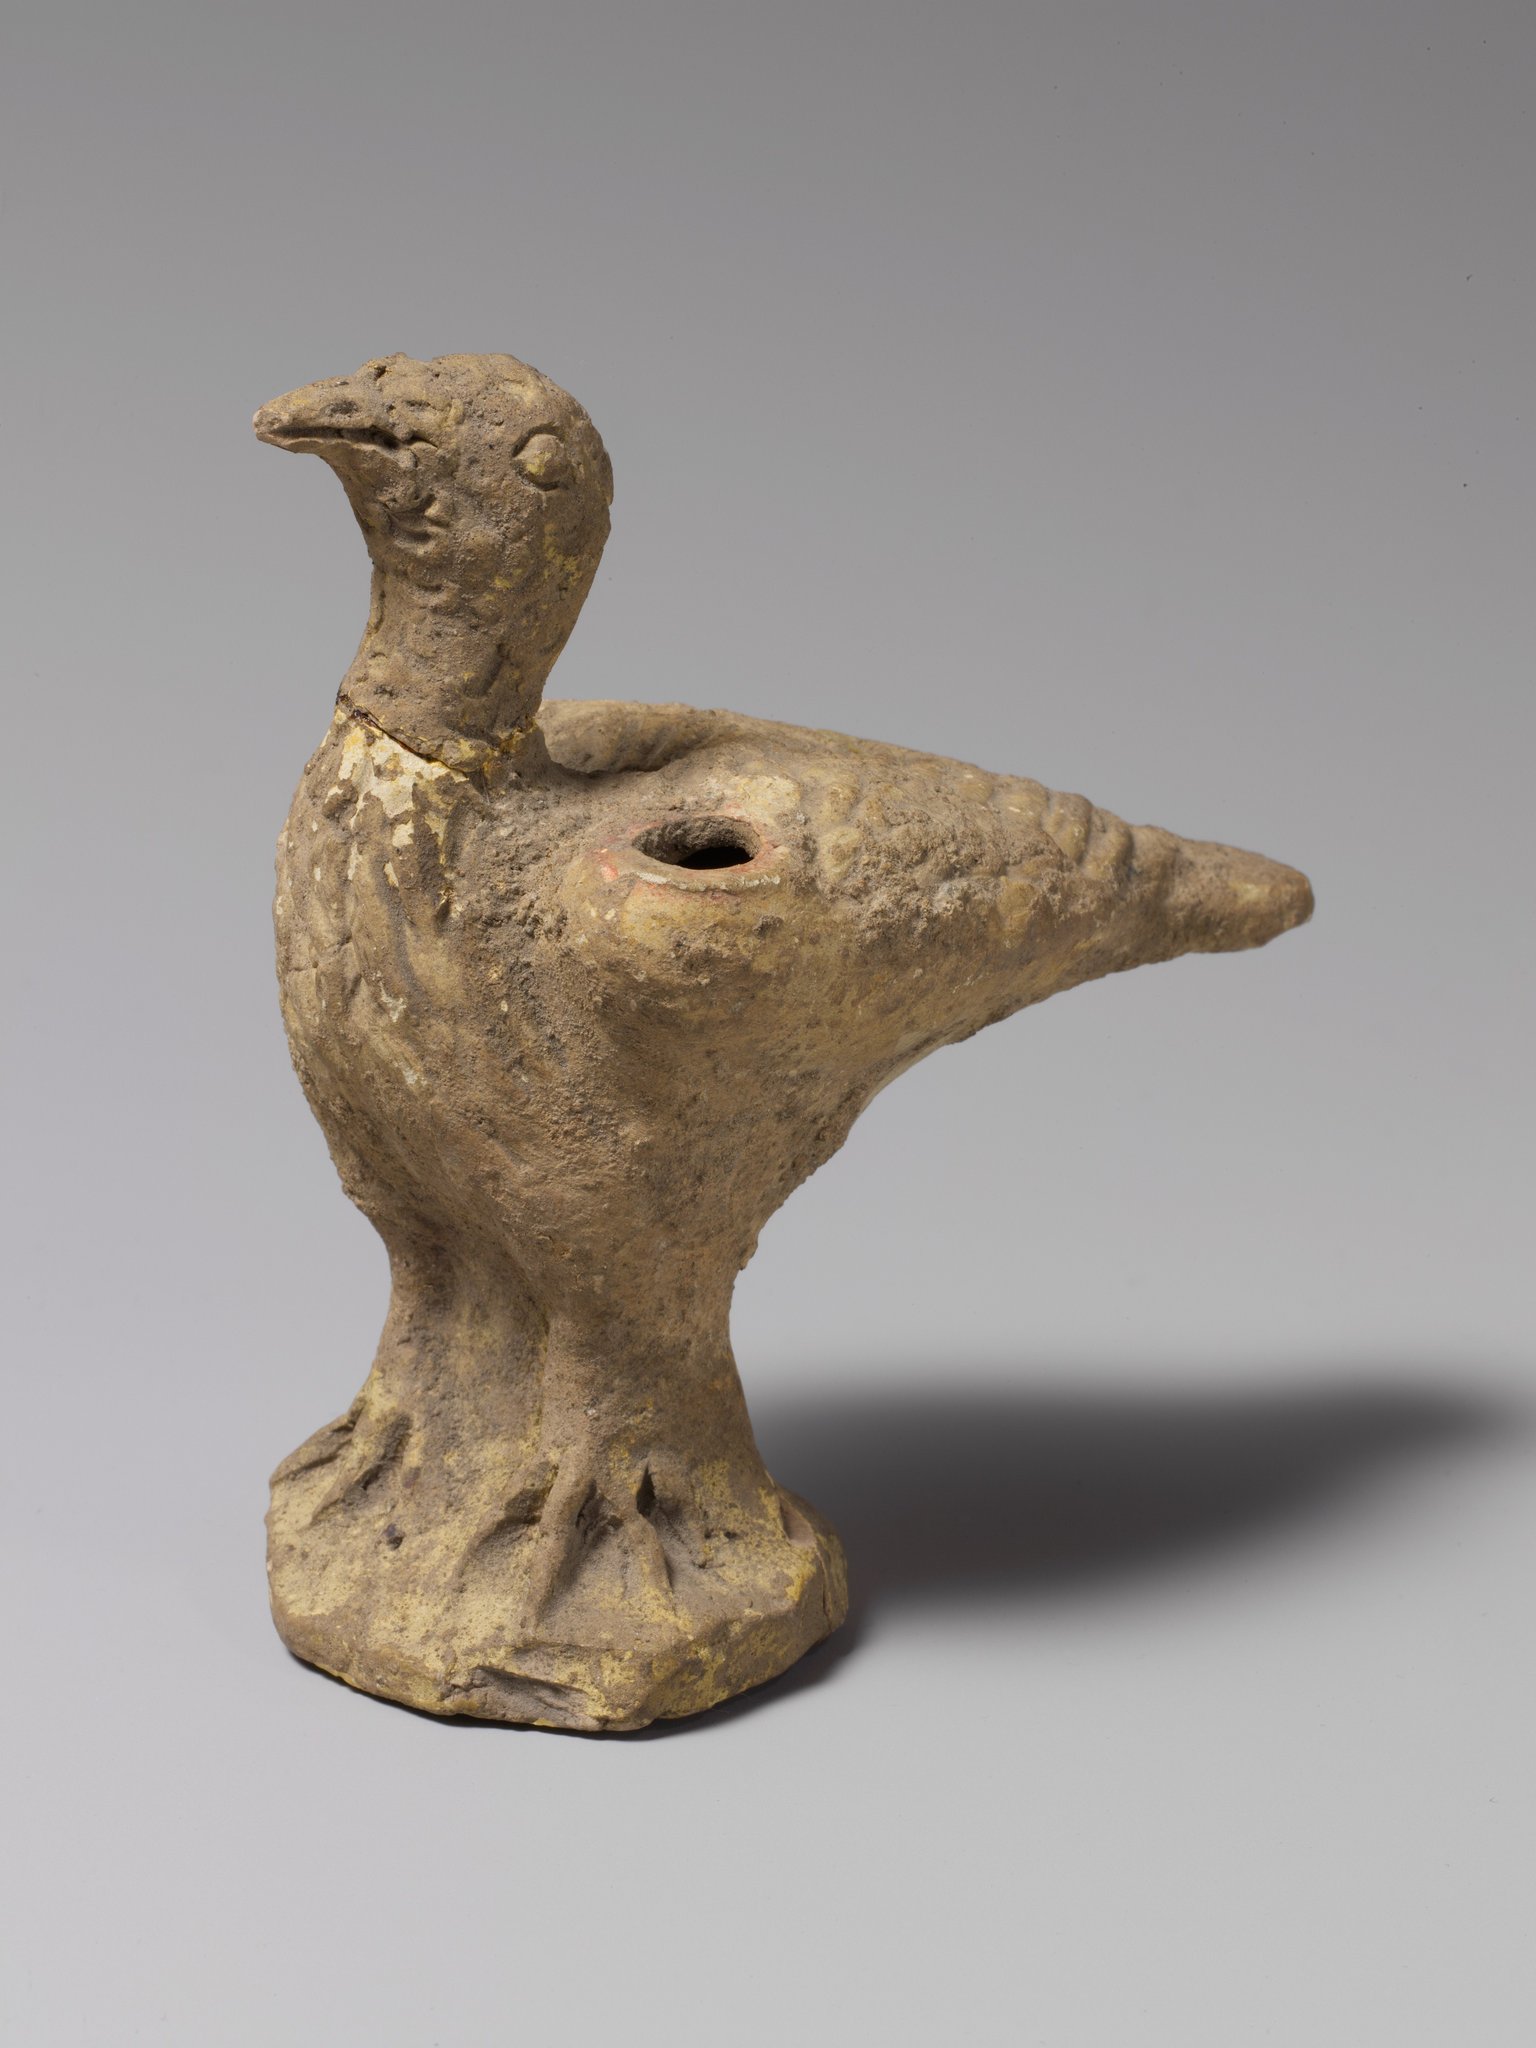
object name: lamp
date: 401-600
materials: earthenware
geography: egypt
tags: birds